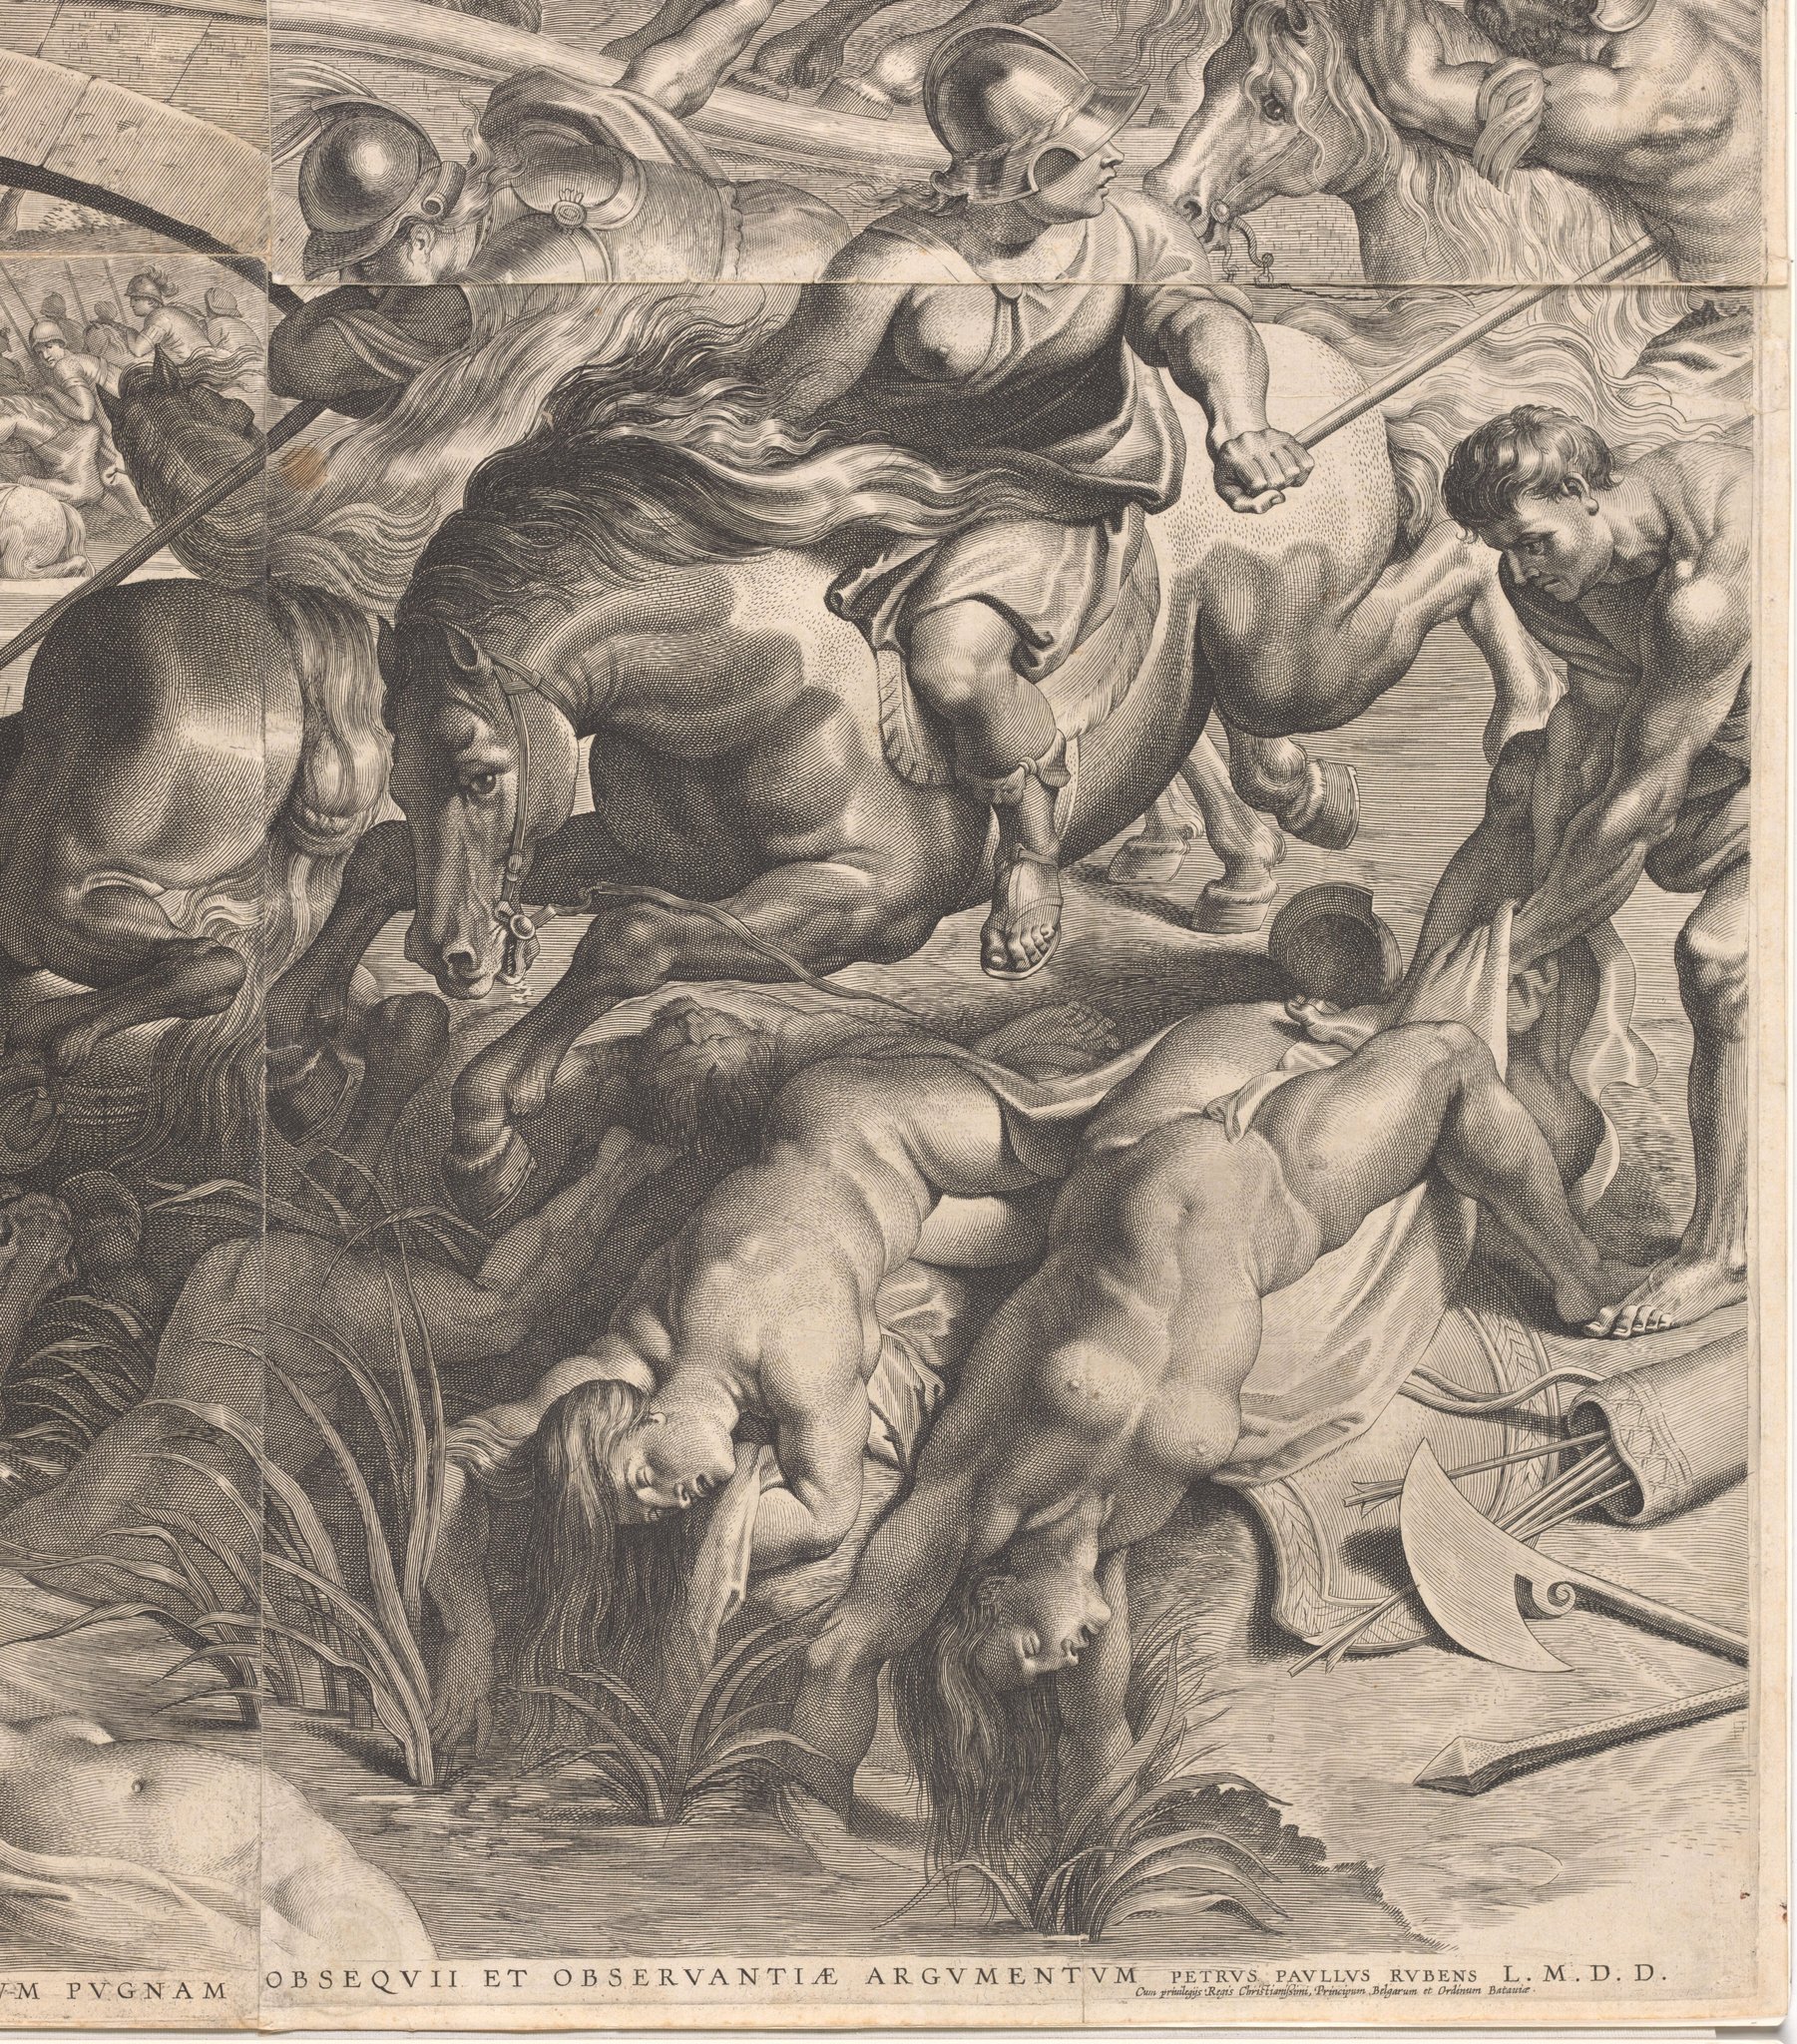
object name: print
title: Slag van de Amazonen (detail)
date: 1623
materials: paper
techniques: engraving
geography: antwerp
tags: battle of amazons; amazonomachy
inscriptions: collector's mark: Lugt 240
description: De koperplaat bevindt zich in de chalcografiecollectie van het Musée du Louvre te Parijs (inv.nr. 844). Het schilderij van Rubens maakt deel uit van de collectie van de Alte Pinakothek te München (inv.nr. 324). De ontwerptekening, toegeschreven aan Van Dyck en opgewerkt door Rubens, bevindt zich in Oxford (Christ Church, inv.nr. 1857).